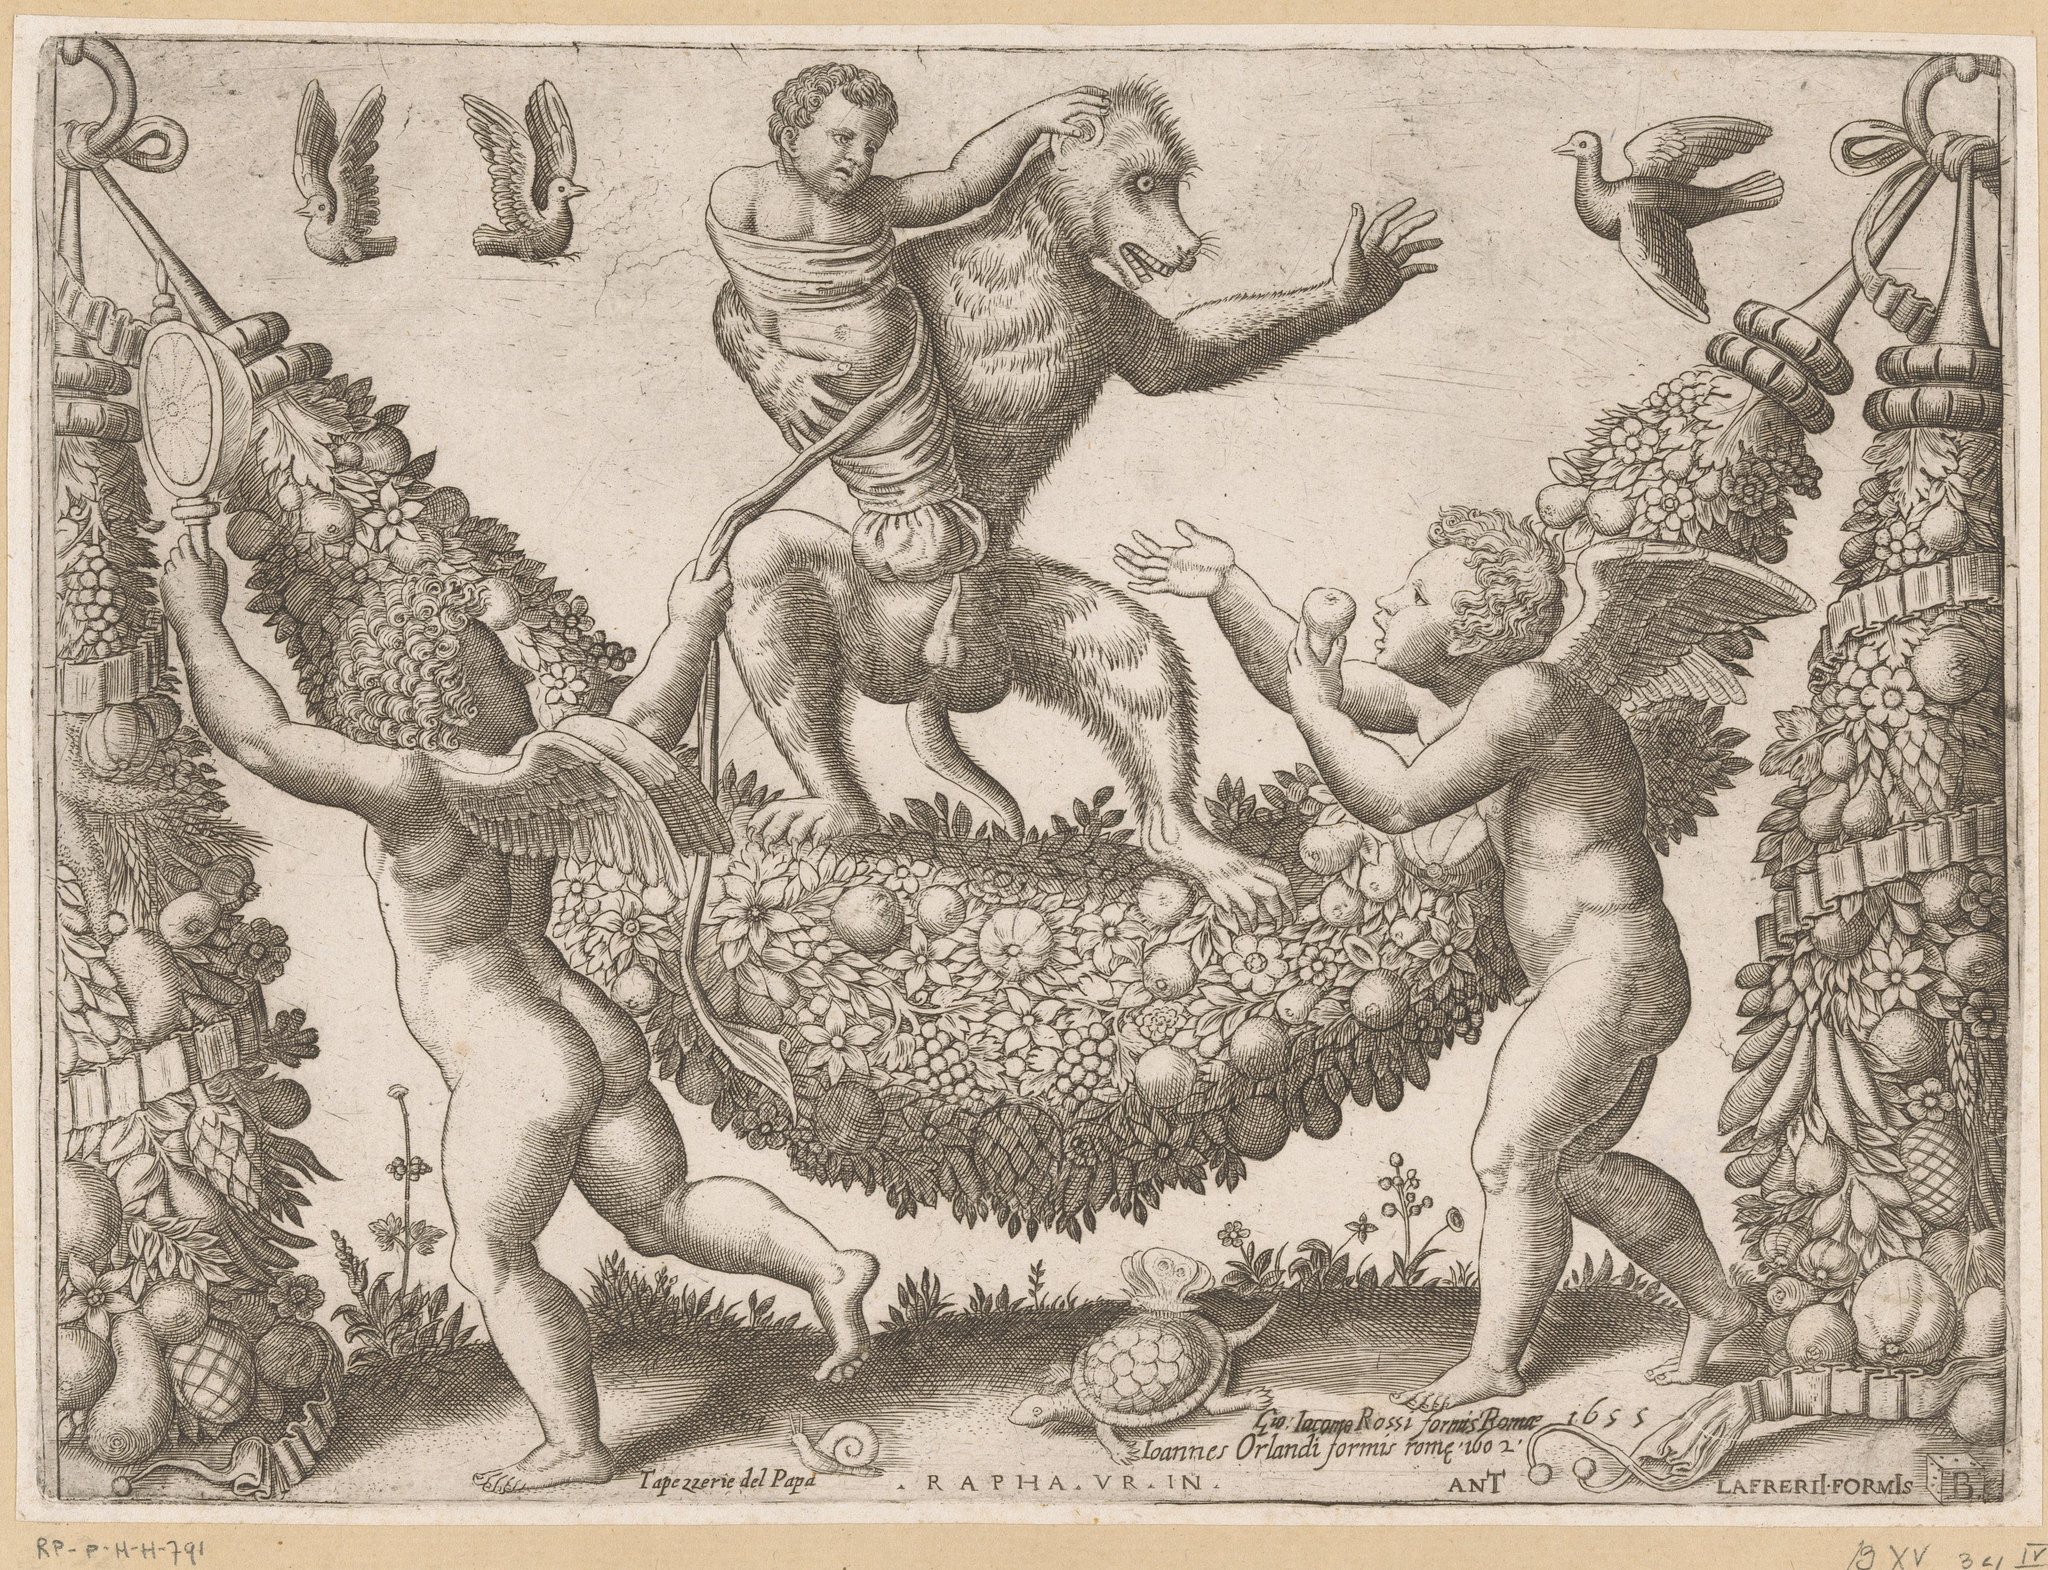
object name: print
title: Tapezzerie de Papa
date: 1602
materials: paper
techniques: engraving, intaglio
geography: rome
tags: tortoises, turtles, monkeys, apes, rattle ~ acoustic signalling, insects: butterfly, molluscs: snail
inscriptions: collector's mark: Lugt 10, collector's mark: ‘Hinloopen’, collector's mark: Lugt 11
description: Op een grote guirlande staat een aap met een in stof gewikkelde putto. Rechts een putto met een vrucht in de hand en links een putto met een rammelaar. Op de grond een slak, een schildpad en een vlinder.